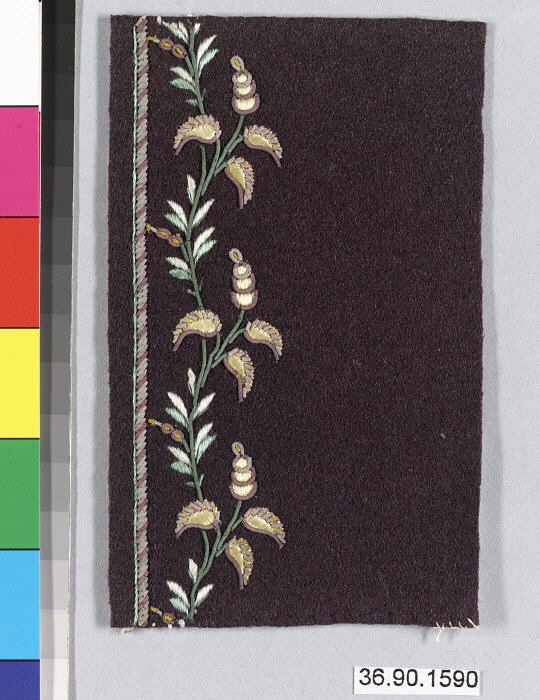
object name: sample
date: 1801-1833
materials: felt, metal thread, silk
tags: plants